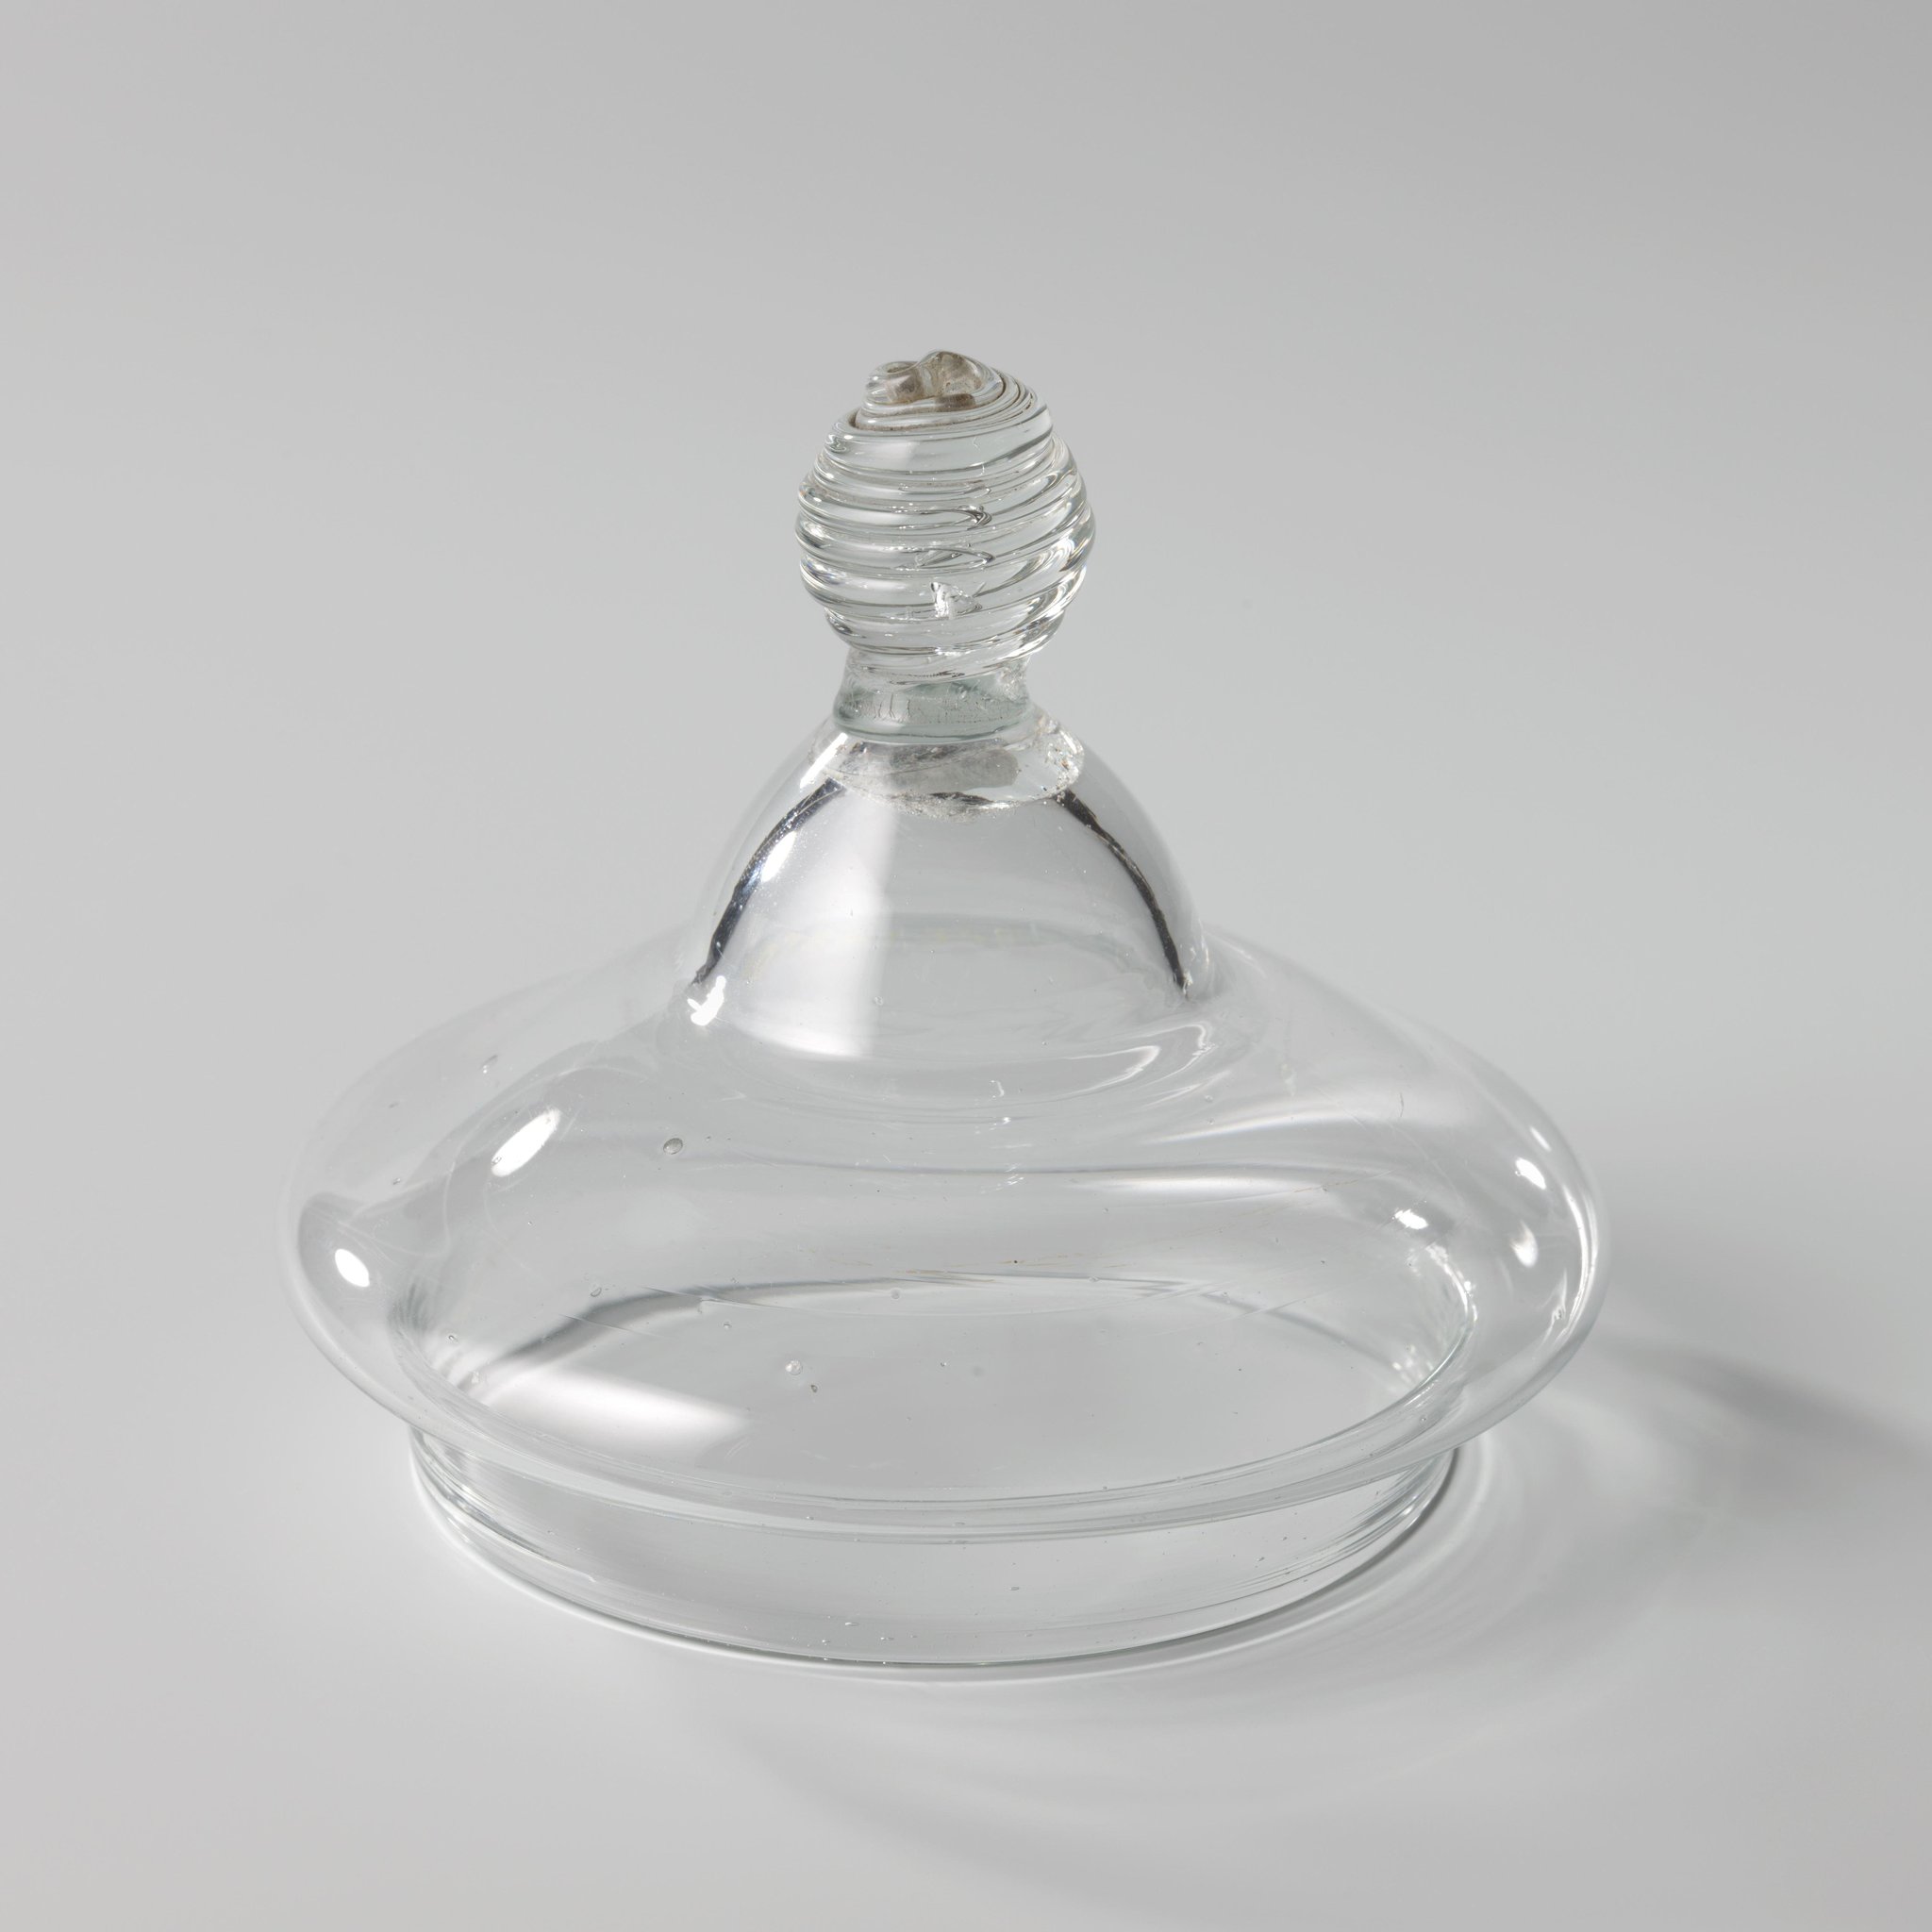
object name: drinking glass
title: Deksel van glas, cilindervormig, op balusterstam met veelvlakkige knoop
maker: Anonymous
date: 1400-1950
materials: glass